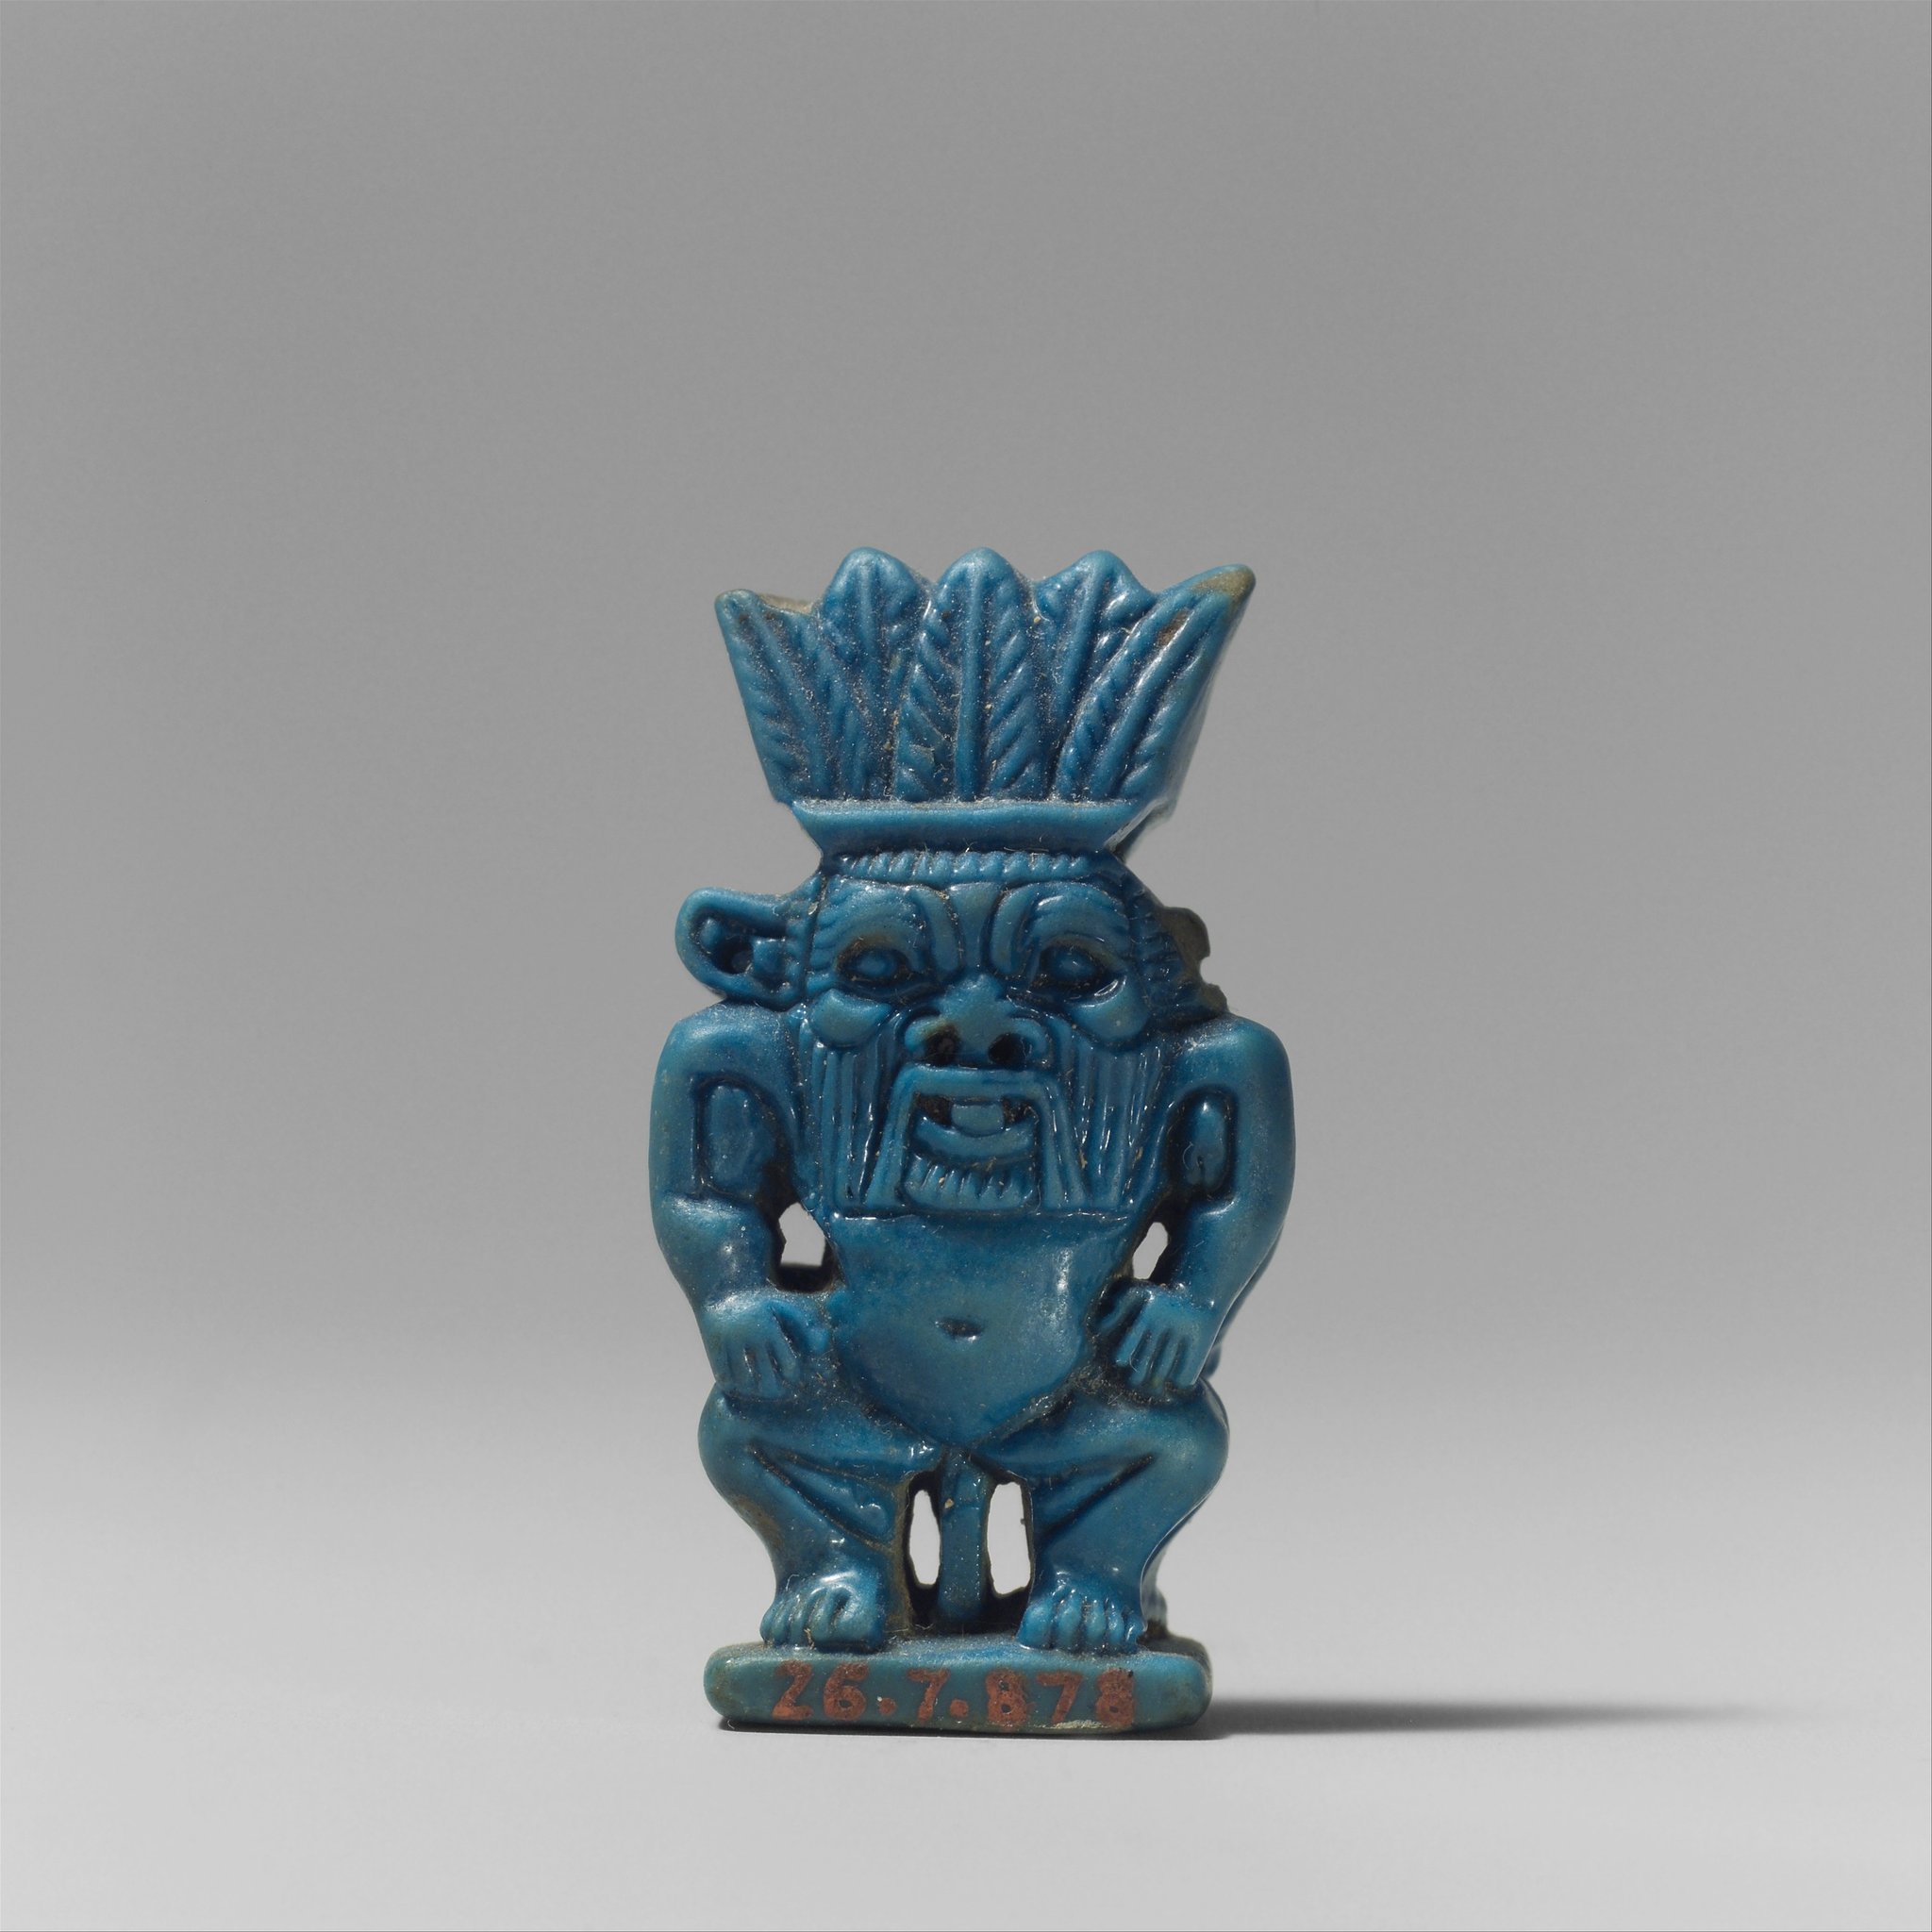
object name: amulet, be image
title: Bes-Image Amulet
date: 1070-712 BCE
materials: faience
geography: egypt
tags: bes